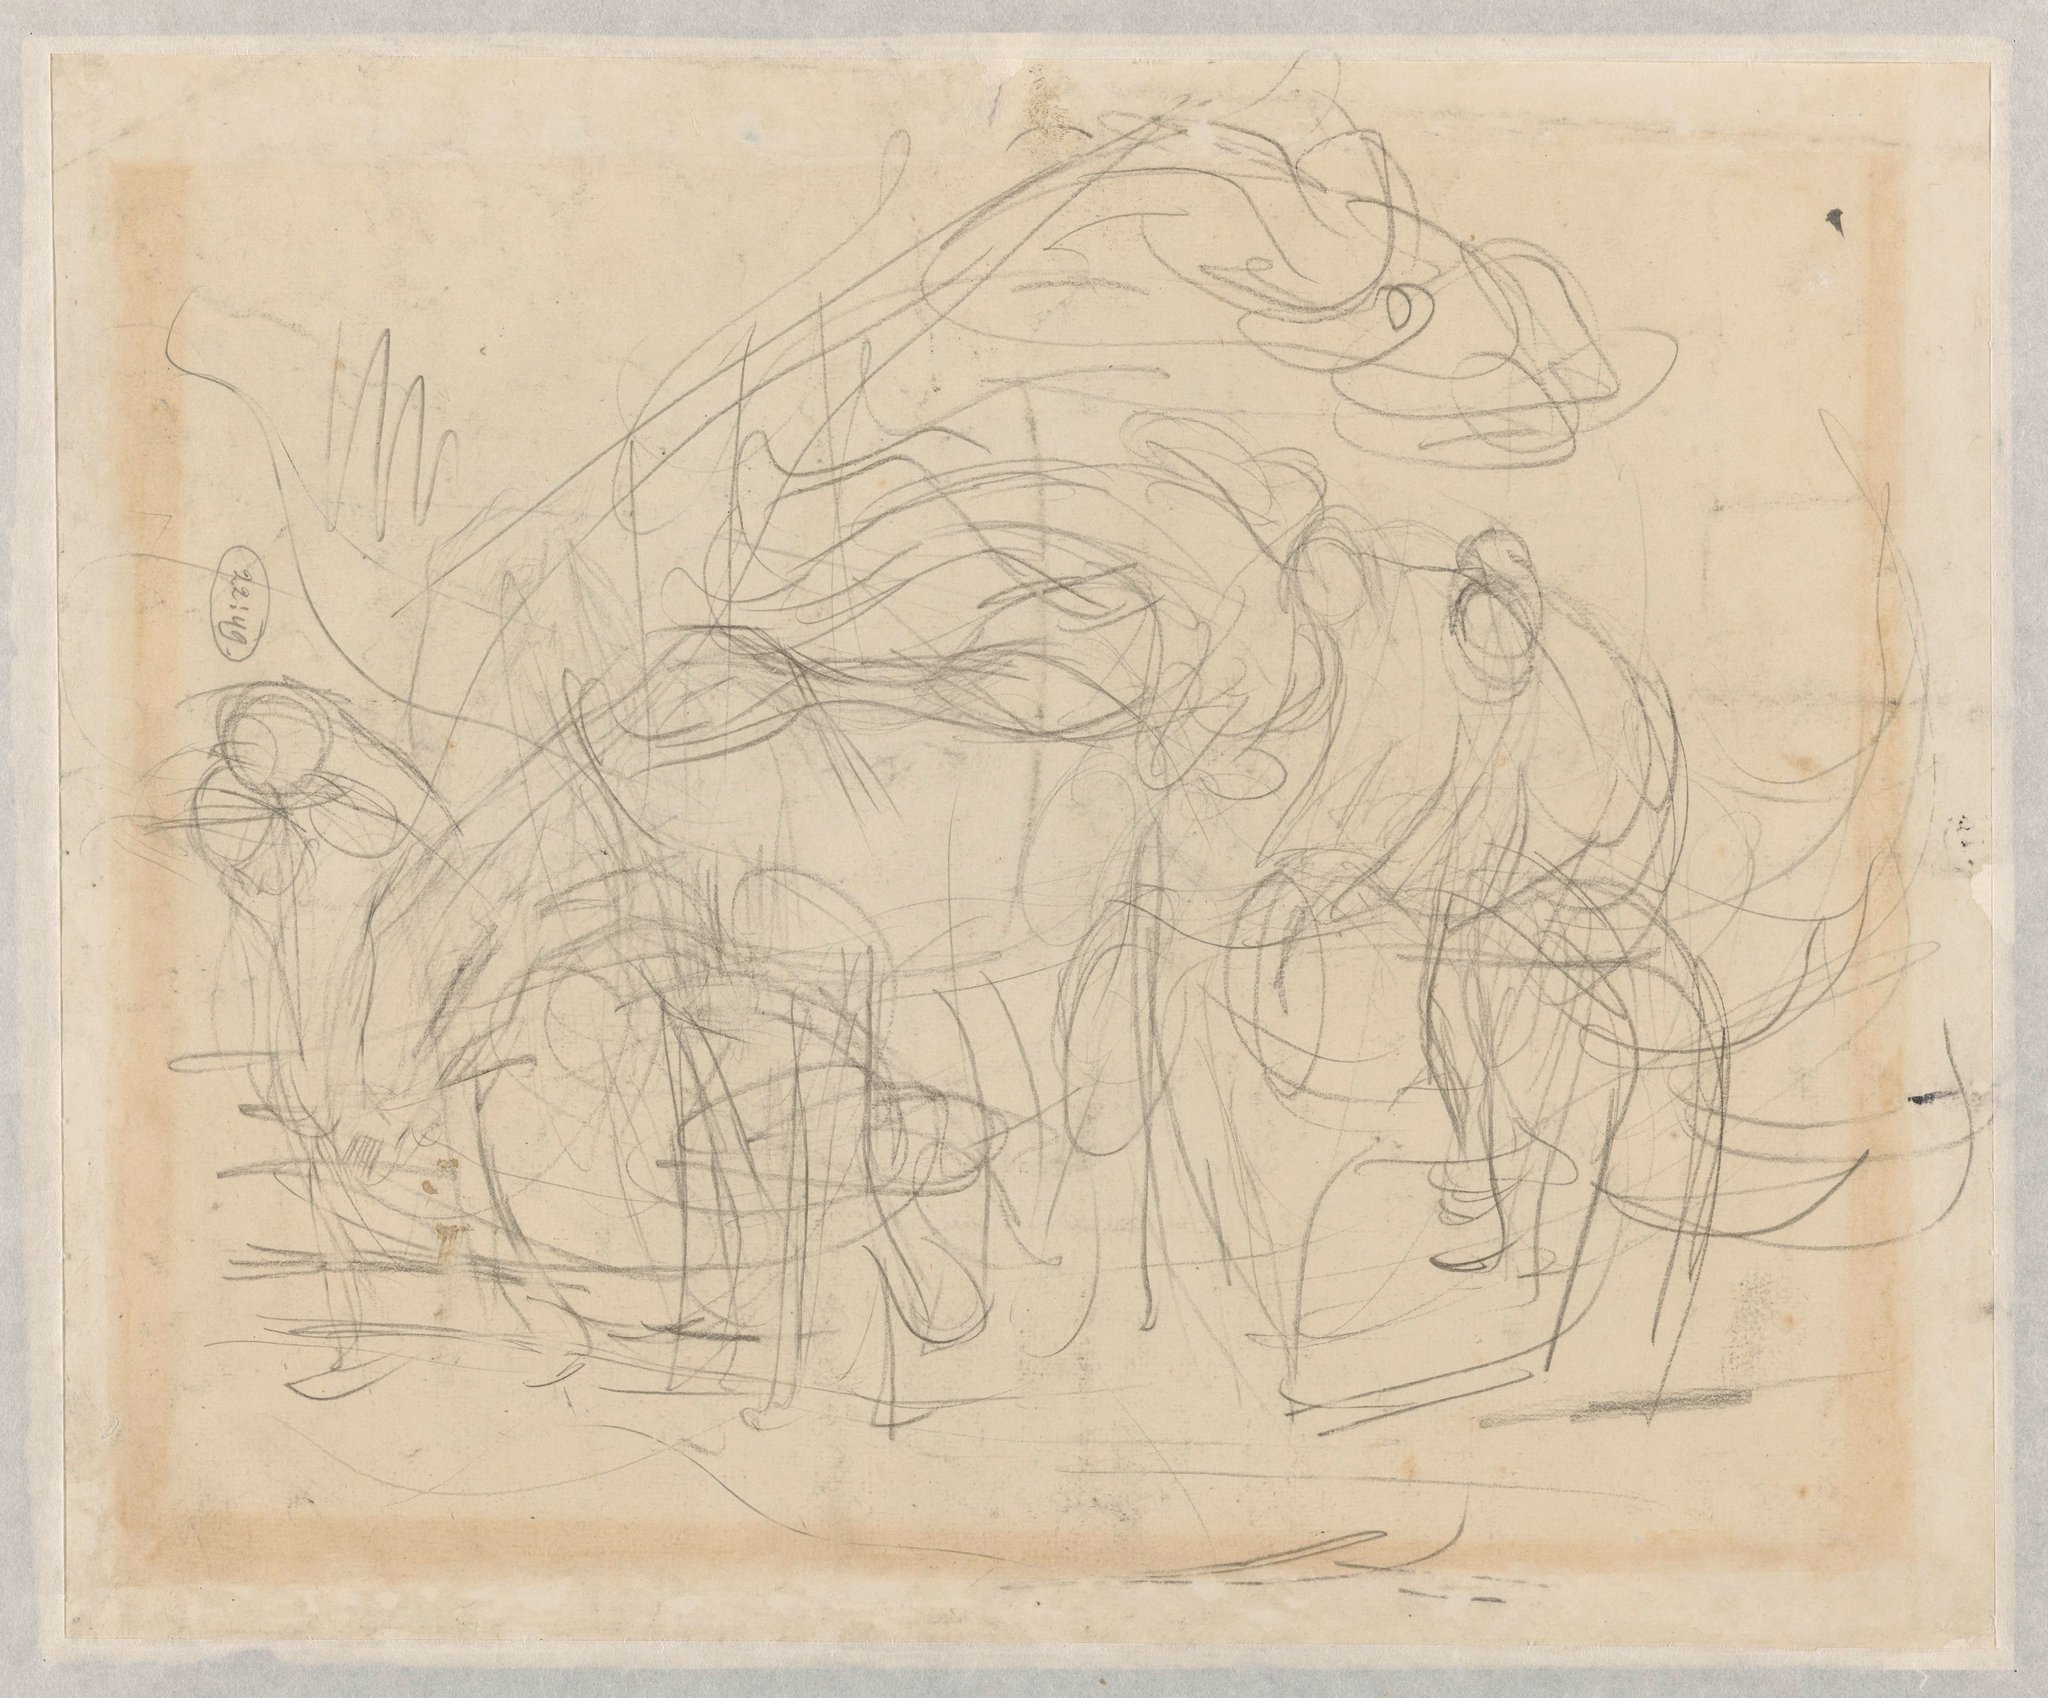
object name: drawing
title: Schets met meerdere figuren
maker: johannes hendricus jurres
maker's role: draughtsman, print maker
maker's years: 1875-1946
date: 1885-1922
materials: chalk, paper